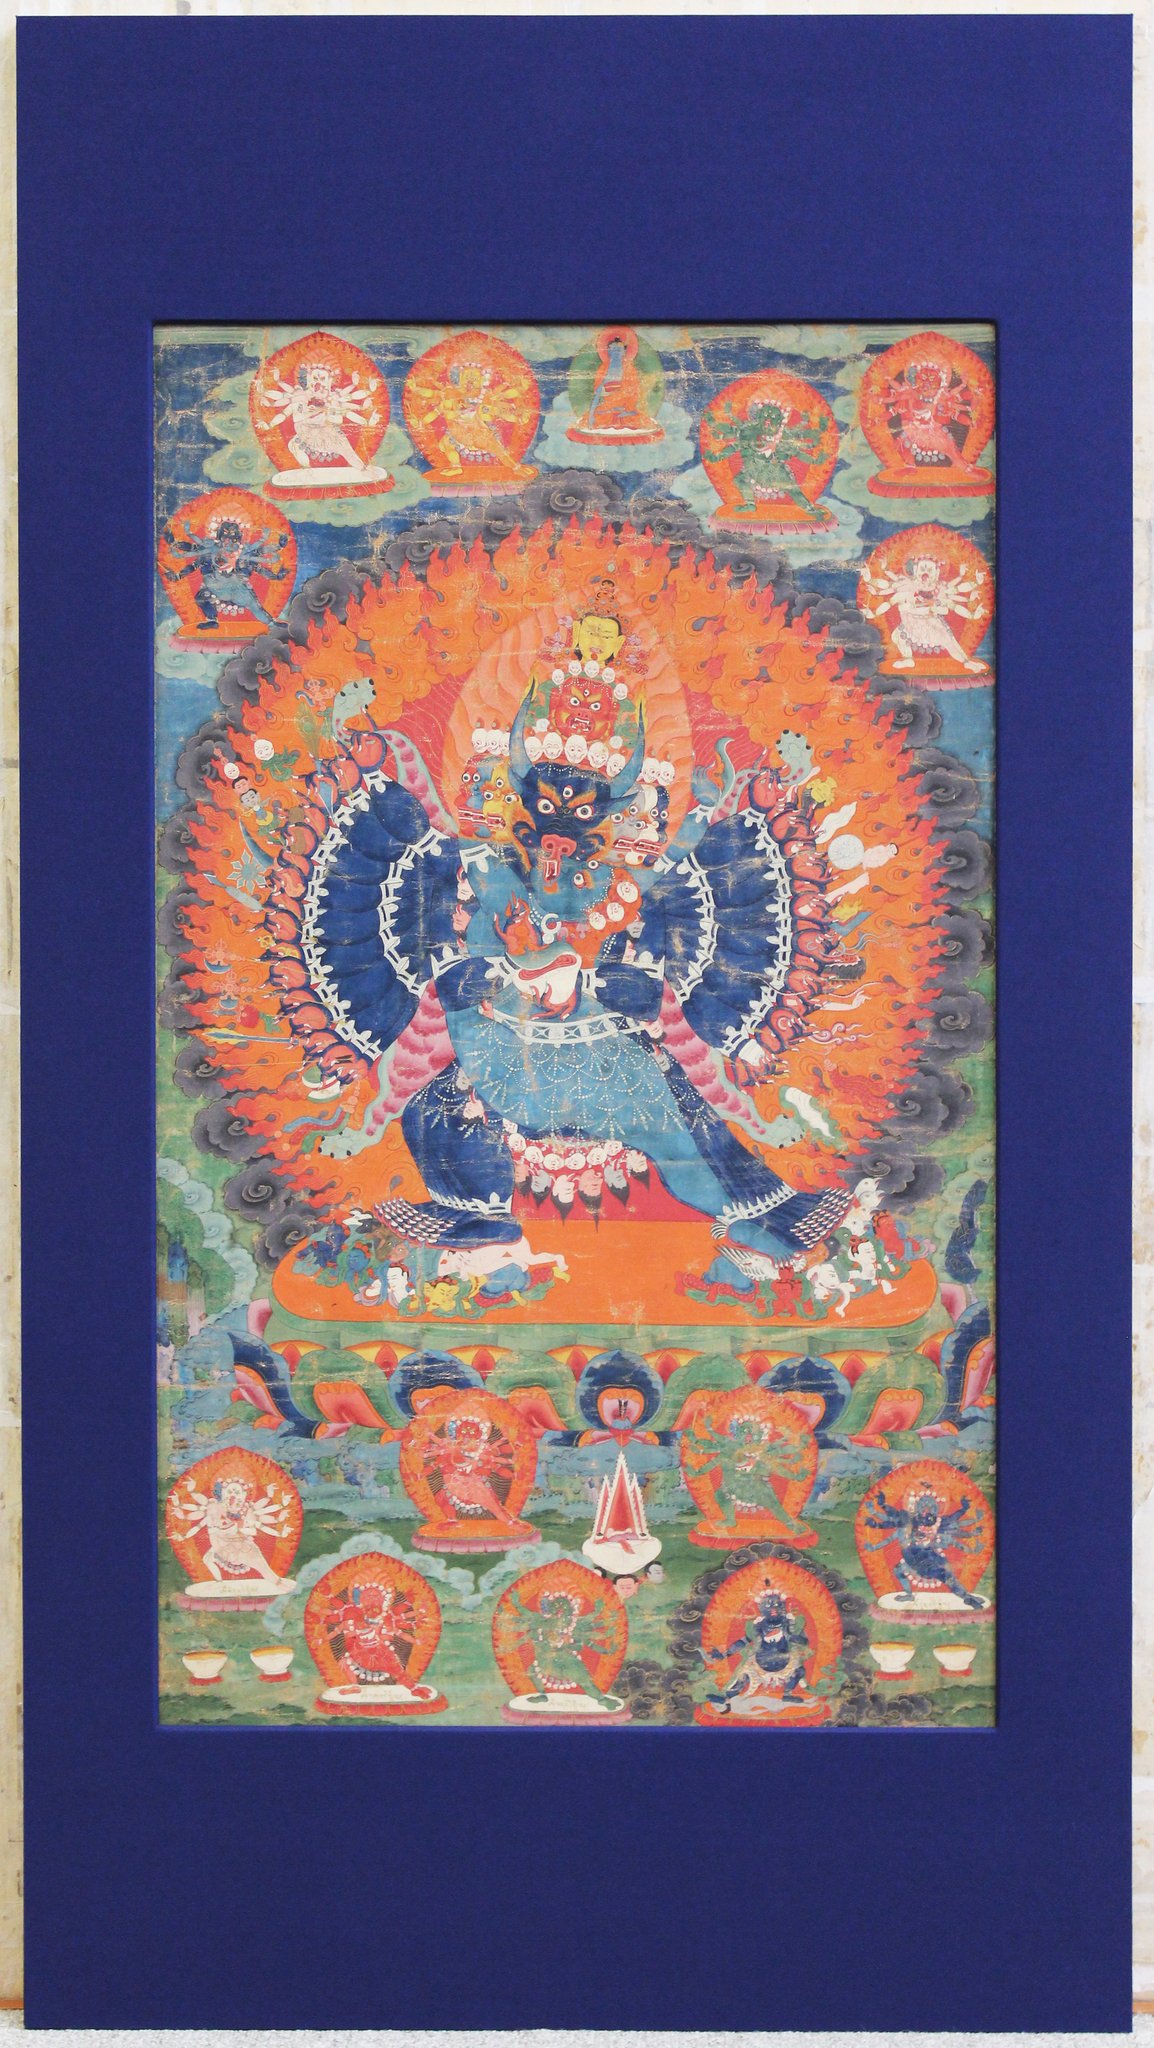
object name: thangka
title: Vajrabhairava with His Consort Vajravetali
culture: tibetan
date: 1701-1800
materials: textile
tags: dogs,buddha,gods